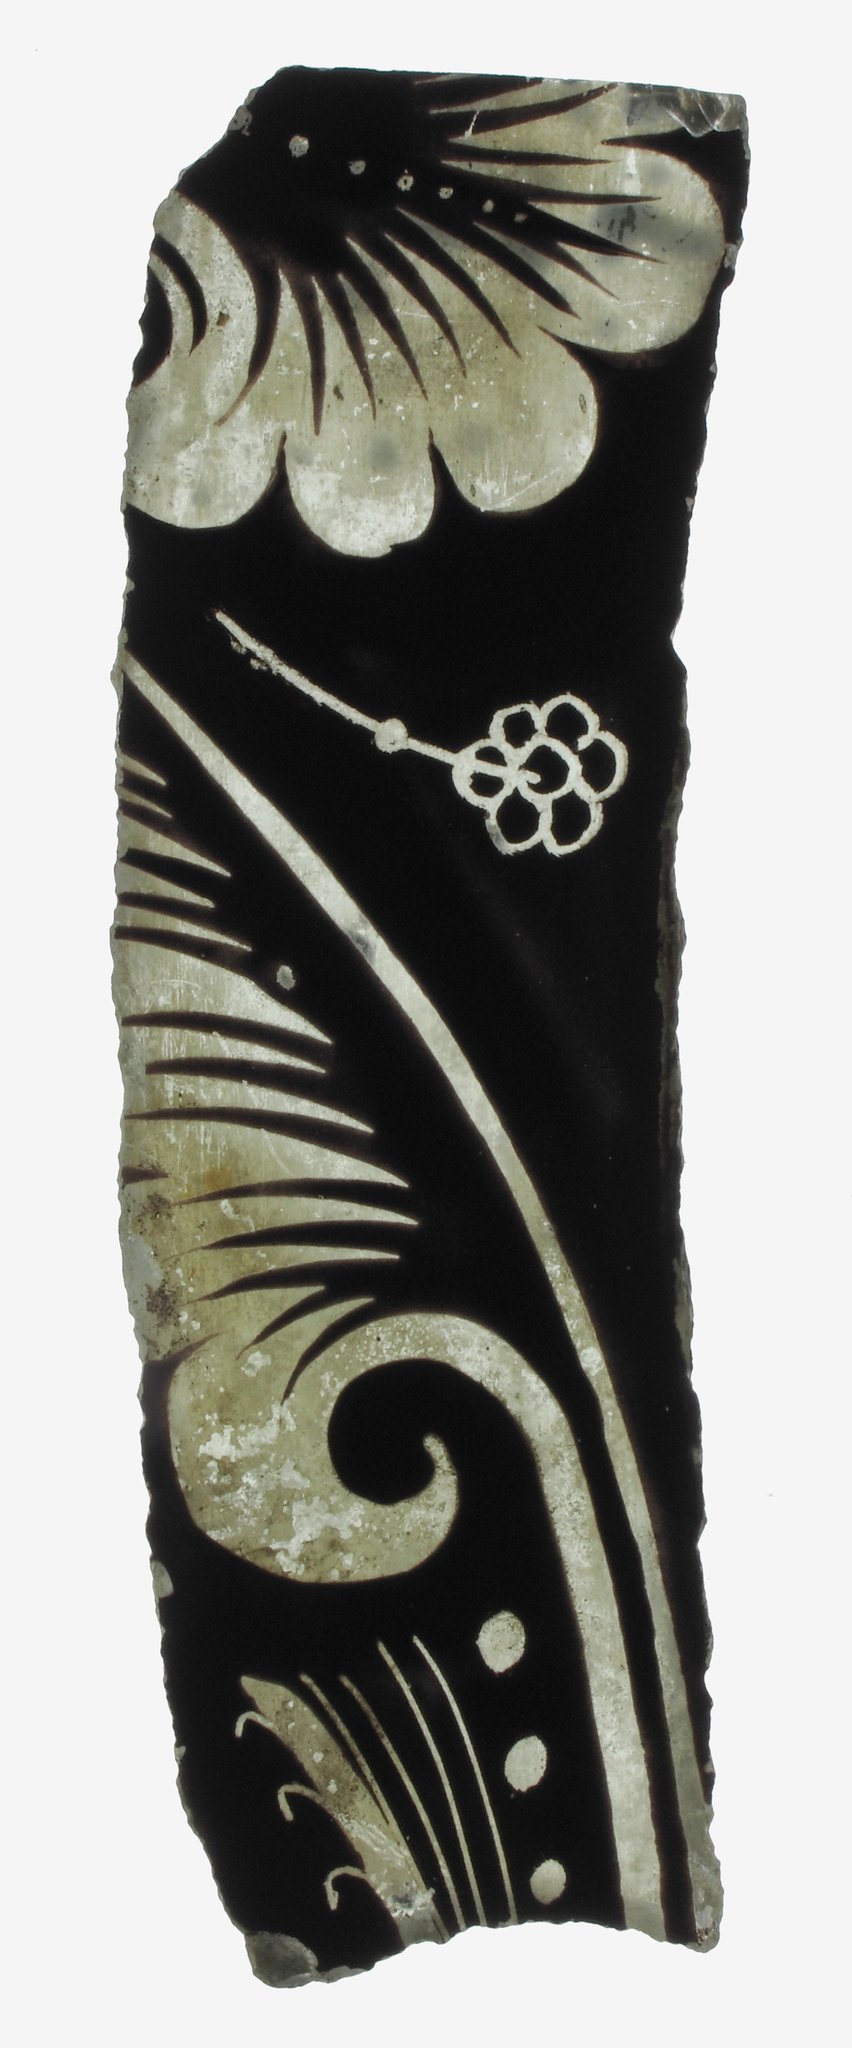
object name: fragment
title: Glass Fragment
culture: european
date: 1101-1200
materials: glass